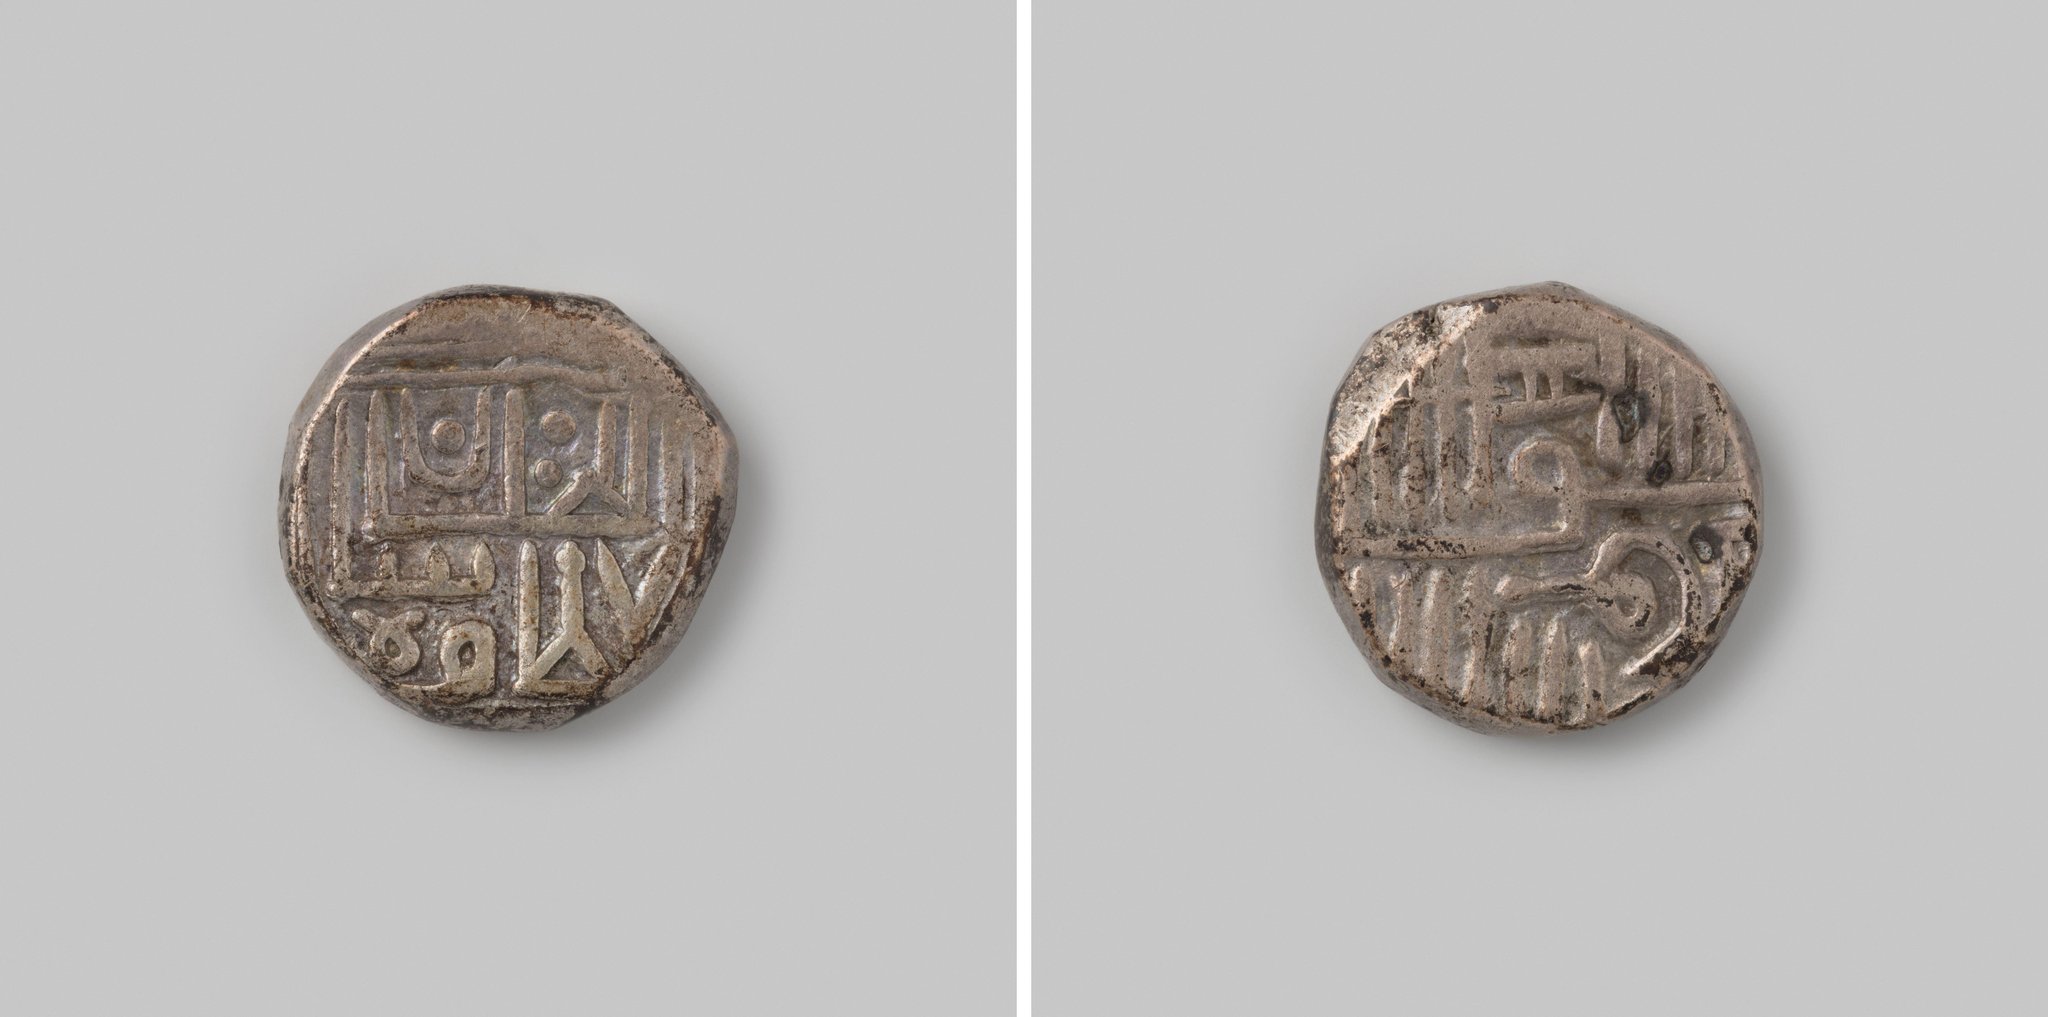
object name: coin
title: Kori uit Gujarat in India van sultan Muzaffir III,156-173 AH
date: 156-173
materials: silver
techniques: striking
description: Zilveren munt. Voorzijde: ondetermineerbare lettertekens . Keerzijde: in Arabisch en Nagari-schrift lettertekens met jaartal in Arabische cijfers [?].